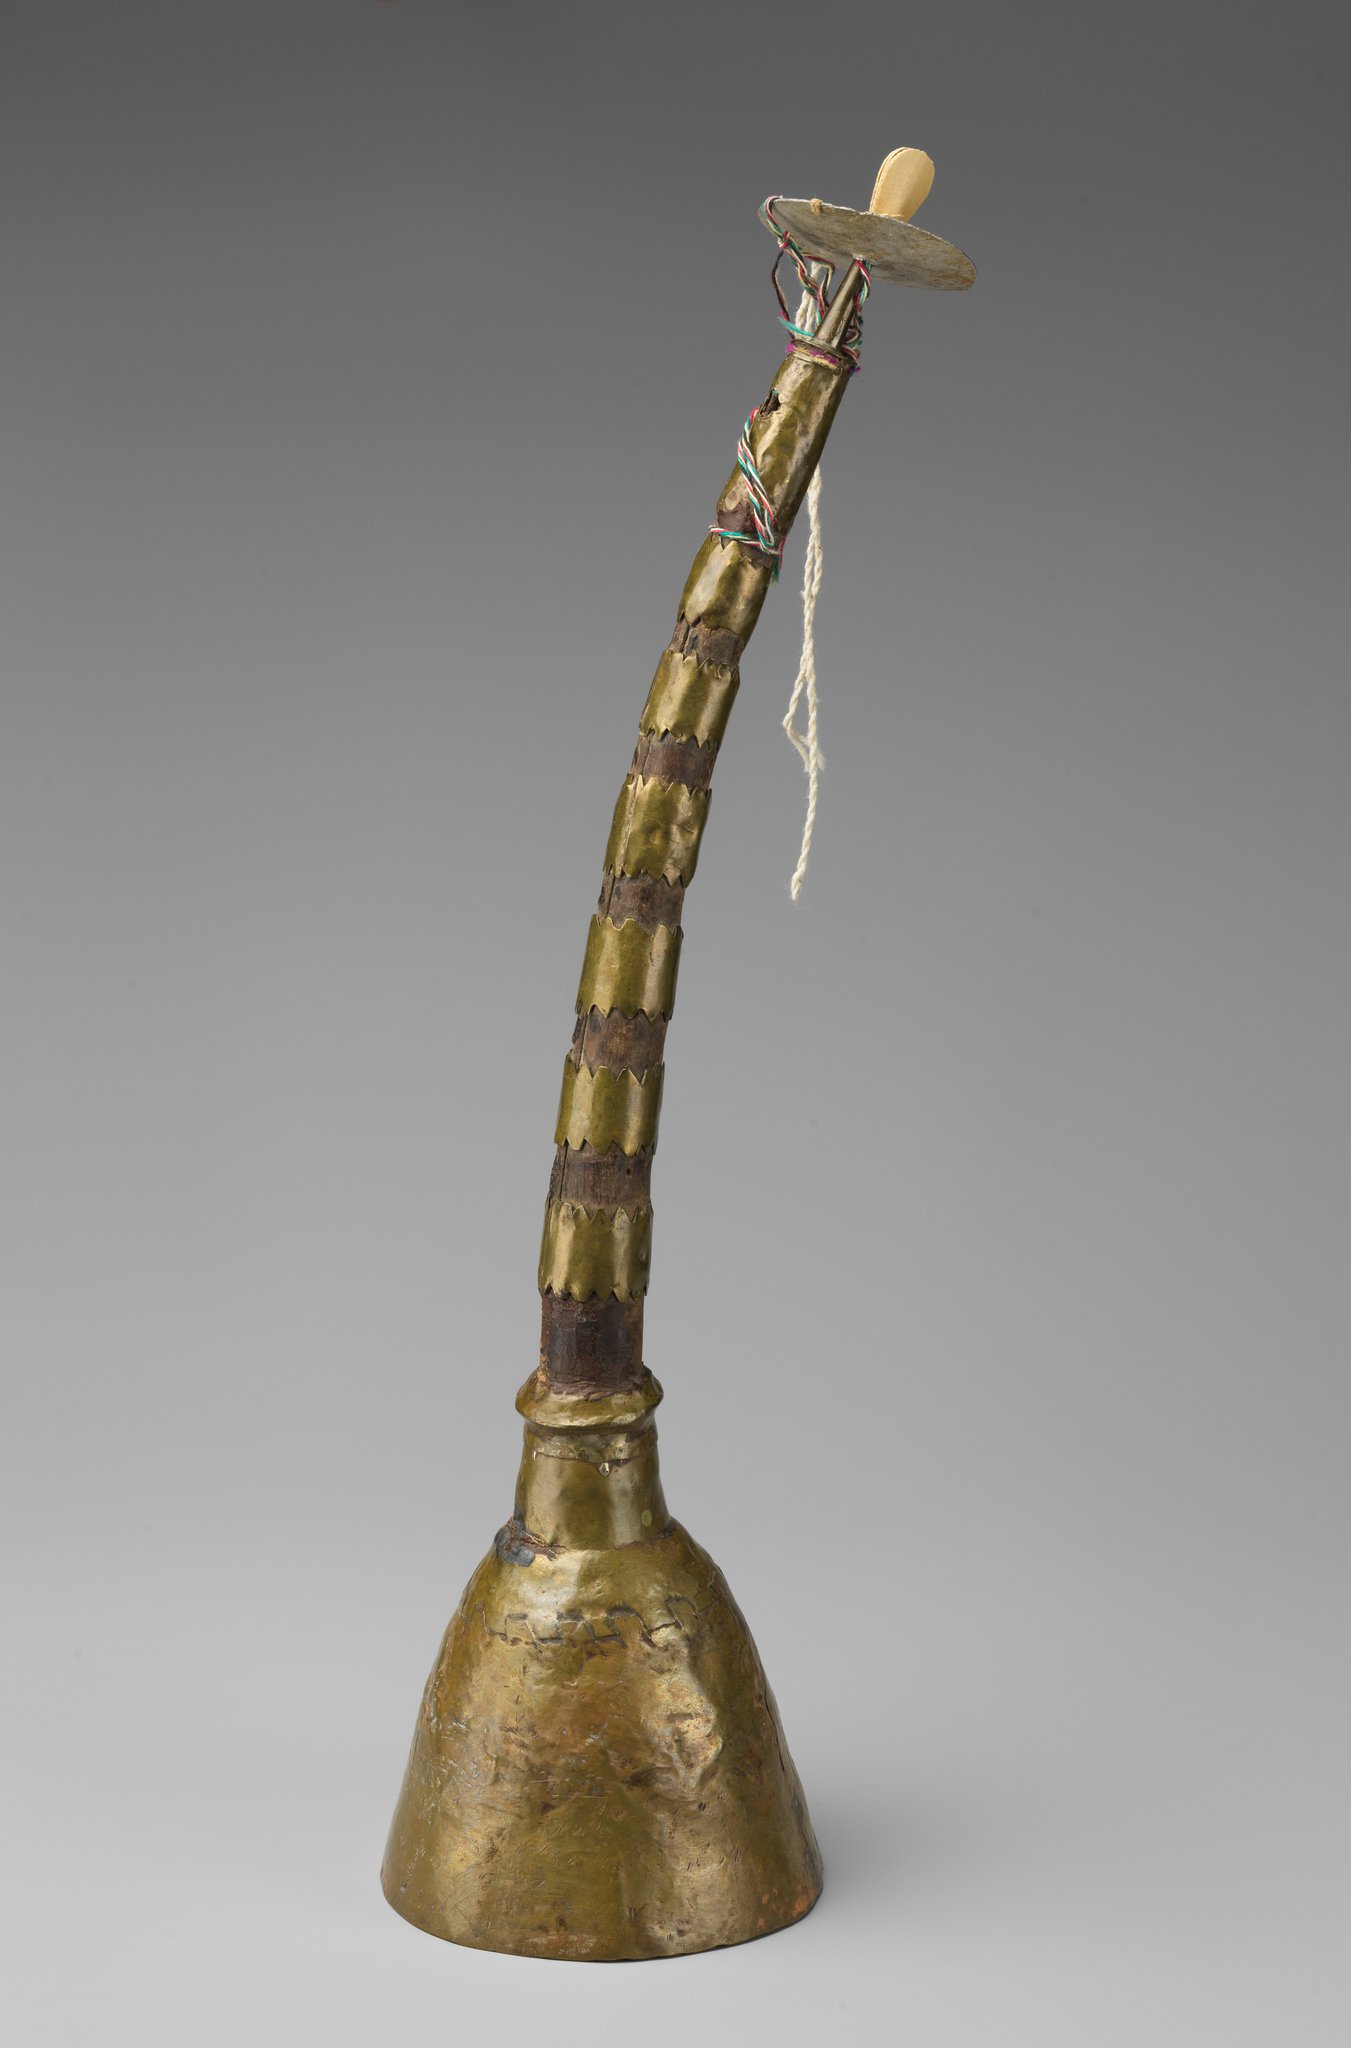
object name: śahanāī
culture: nepalese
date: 1801-1900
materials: brass, wood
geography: nepal